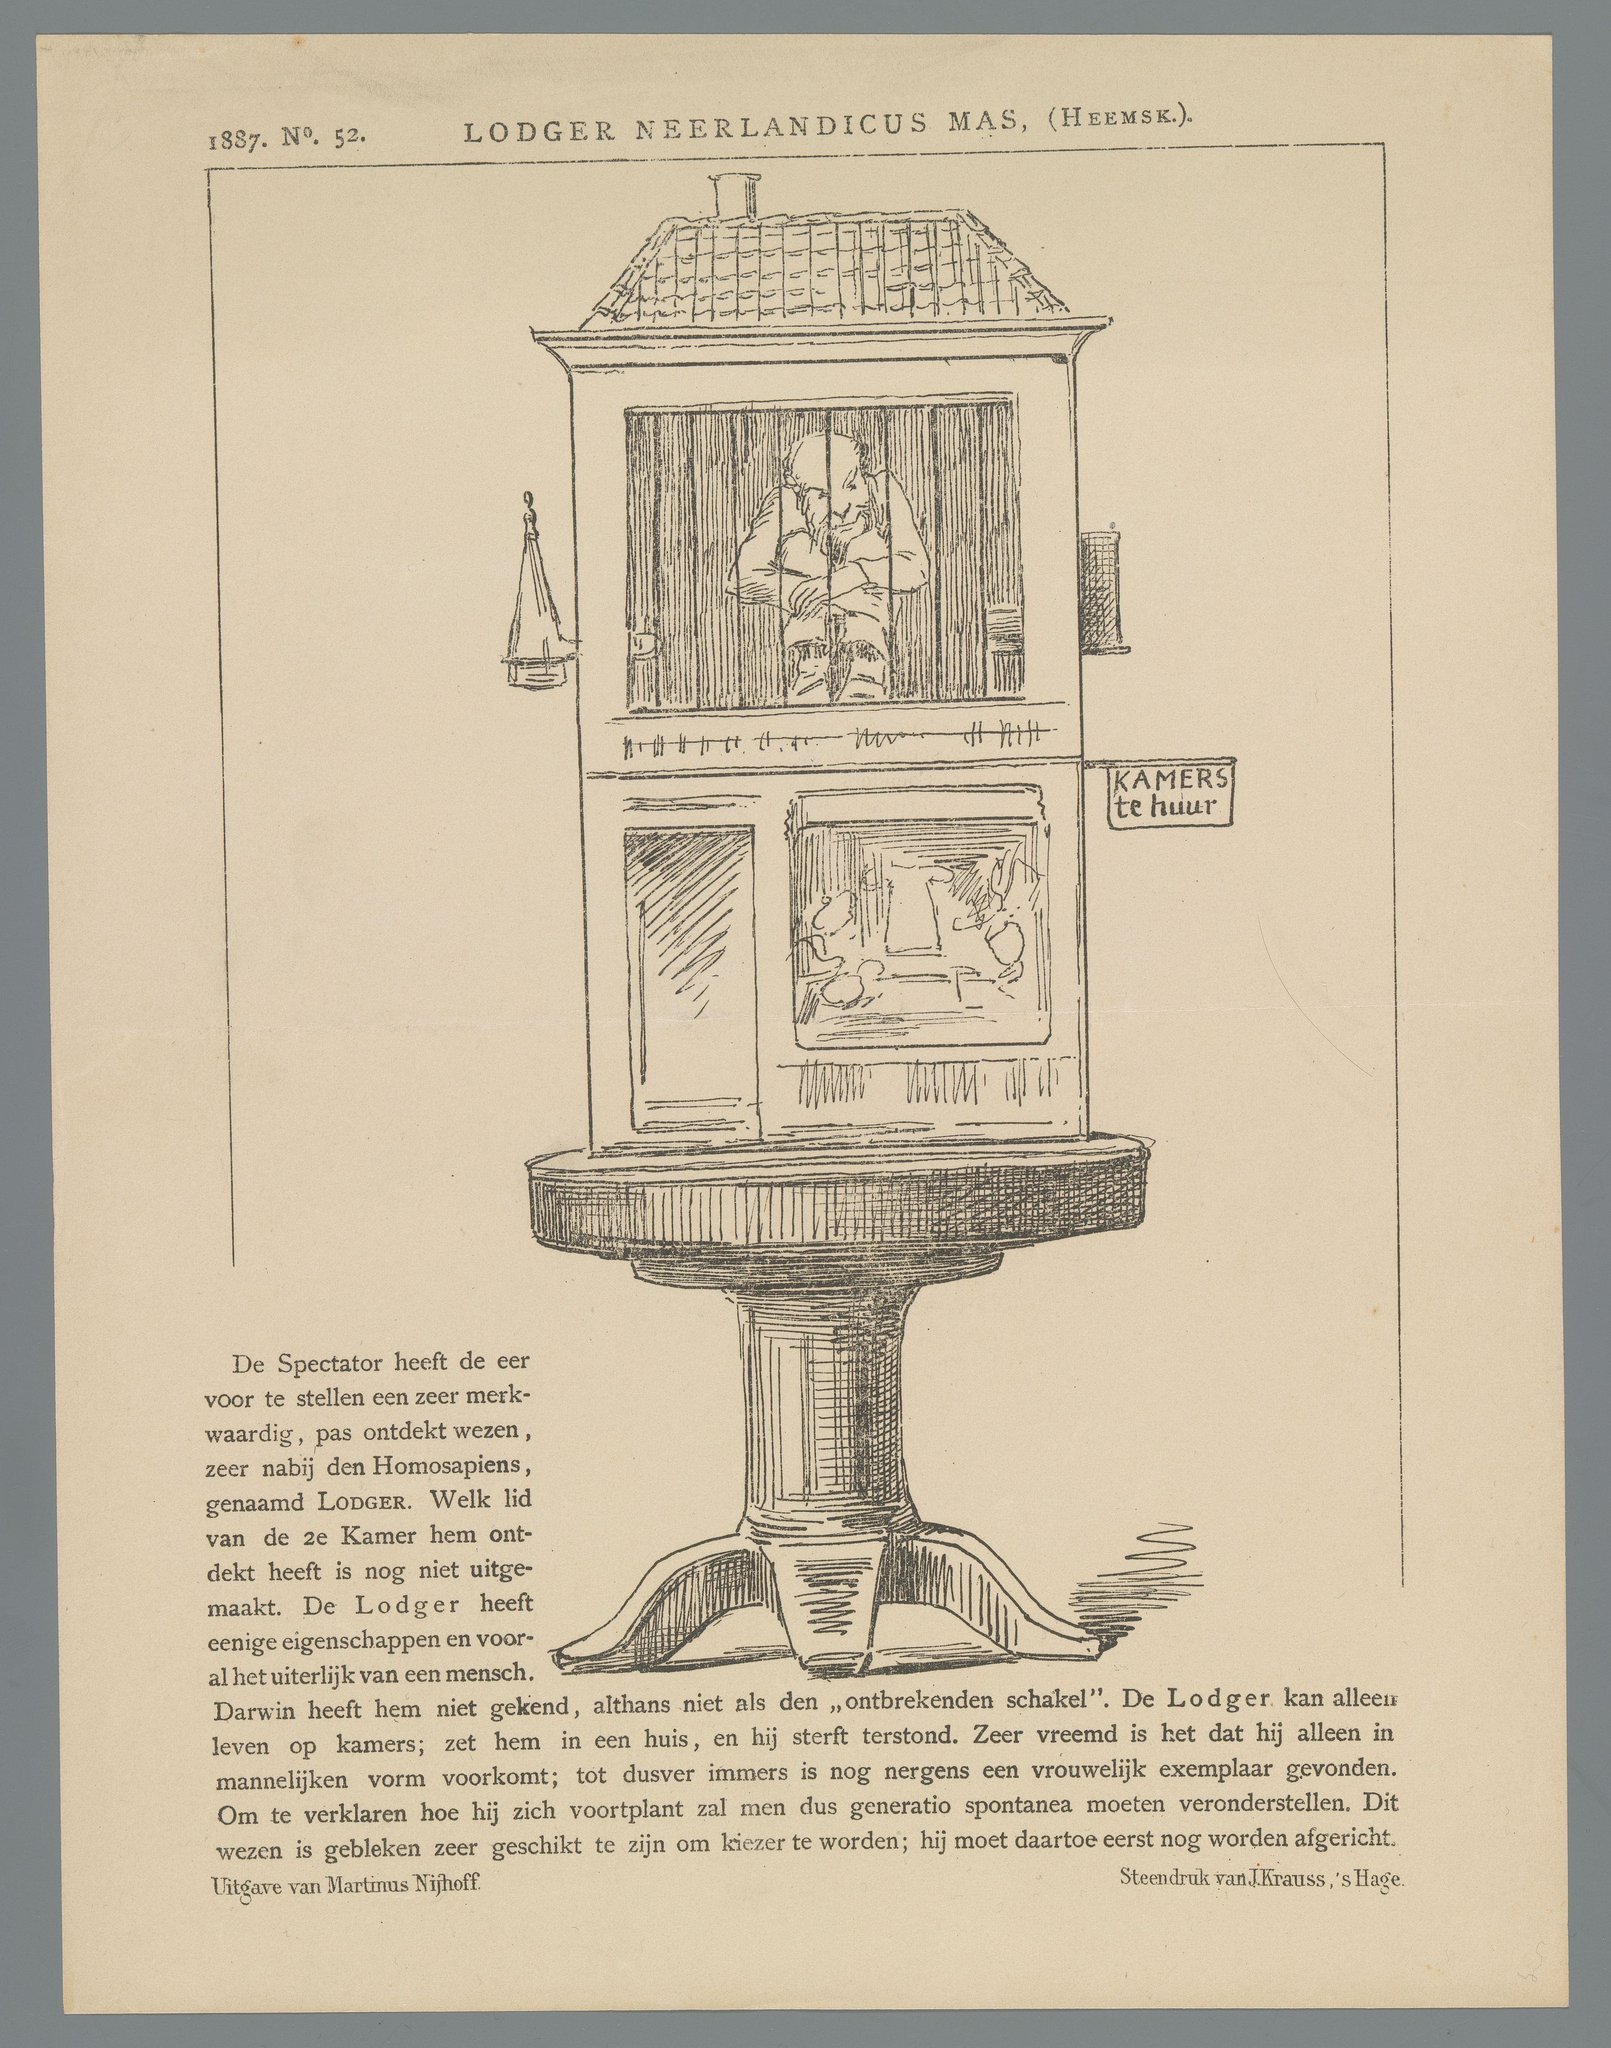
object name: cartoon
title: Spotprent op minister Heemskerk, 1887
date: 1887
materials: paper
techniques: lithograph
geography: netherlands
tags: amsterdam, the hague, politician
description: Spotprent op minister Heemskerk. Plaat verschenen bij het weekblad De Nederlandsche Spectator, nr. 52, 1887.